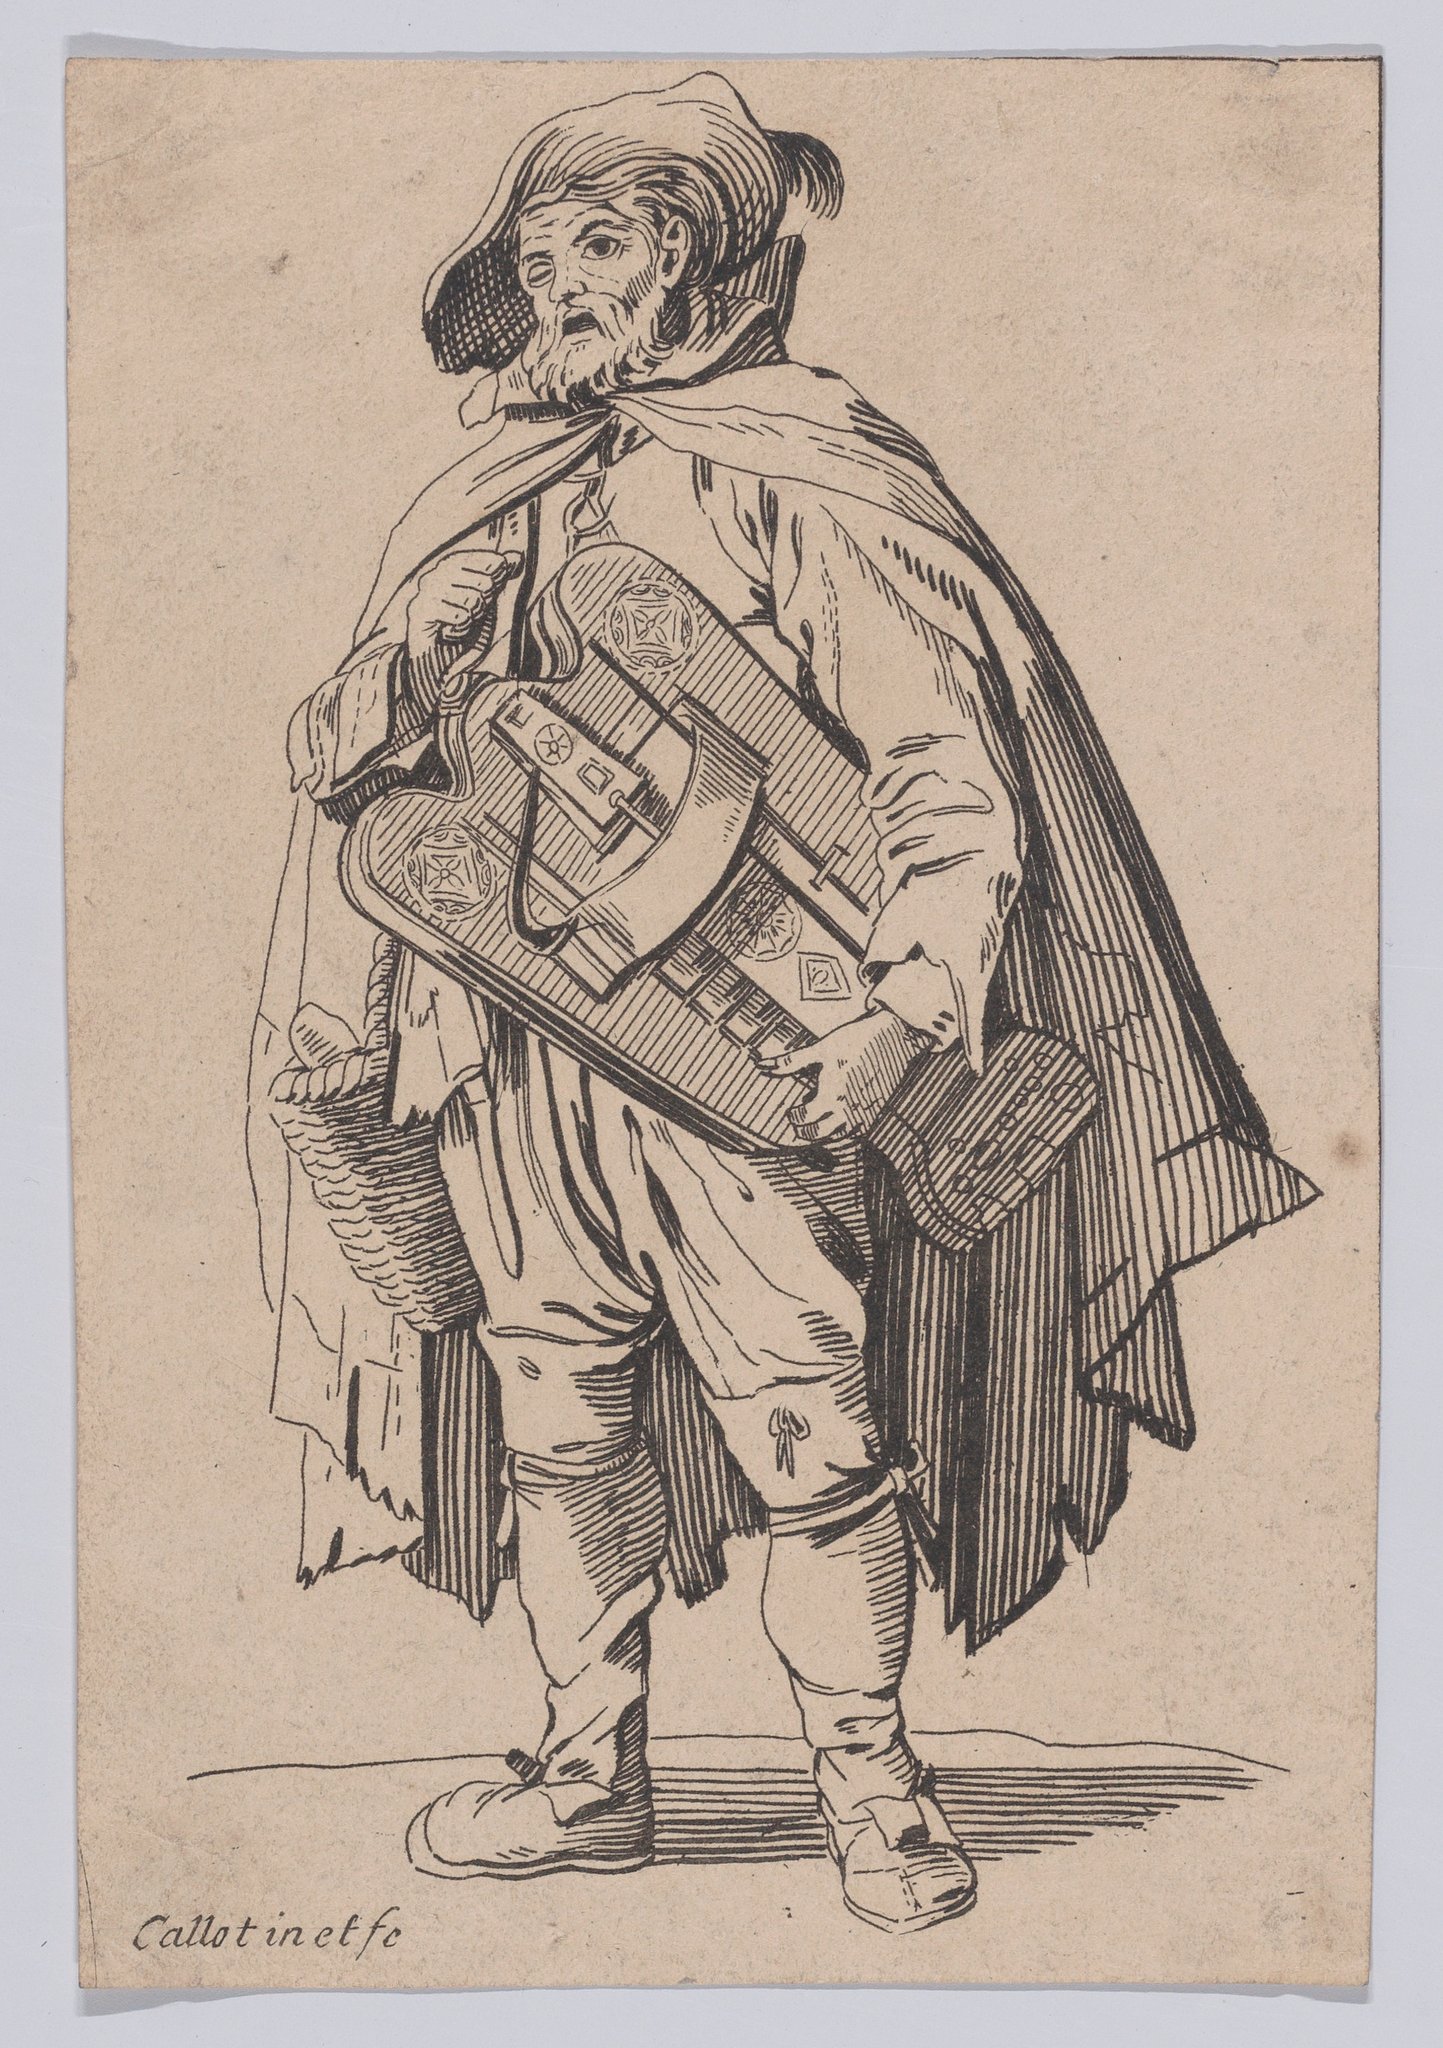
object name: print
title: Reverse Copy of Le Joueur de Vielle (The Hurdy-Gurdy Player), from "Les Gueux suite appelée aussi Les Mendiants, Les Baroni, ou Les Barons" (The Beggars, also called the Barons)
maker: Anonymous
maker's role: artist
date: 1601-1700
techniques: etching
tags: men